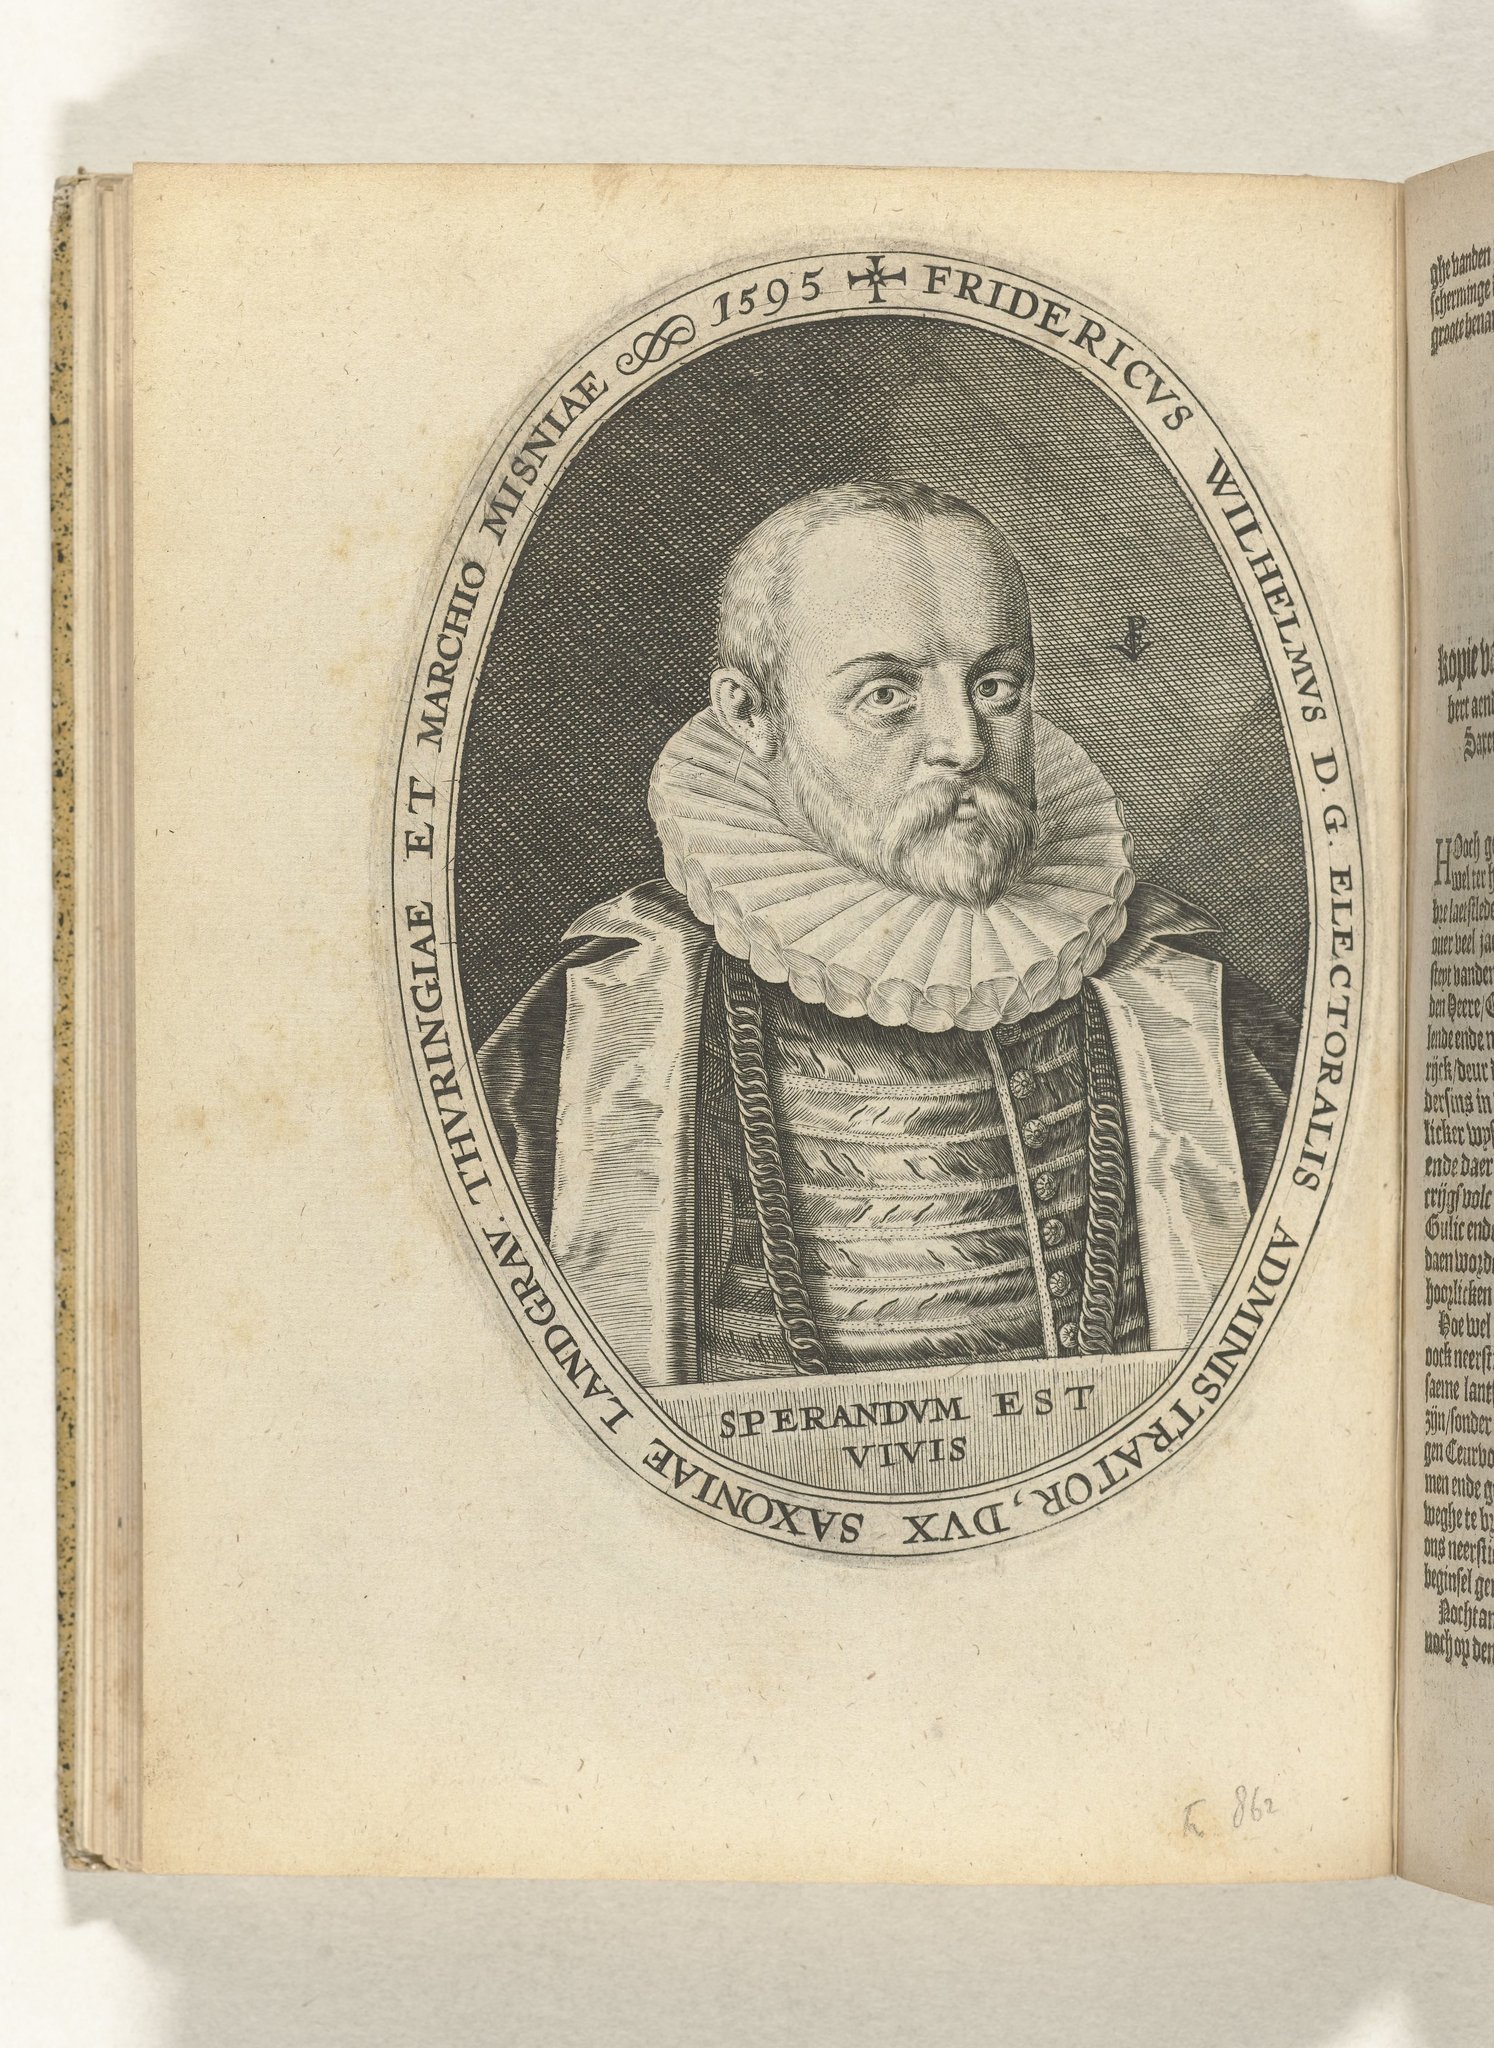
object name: print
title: Portret van Frederik Willem, hertog van Saxen-Weimar, 1595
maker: crispijn van de passe (i)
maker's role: draughtsman, print maker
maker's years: 1564-1637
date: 1595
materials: paper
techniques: engraving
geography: low countries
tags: weimar, hertog, frederik willem i (hertog van saksen-weimar), tachtigjarige oorlog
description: Portret van Frederik Willem, hertog van Saxen-Weimar, 1595. Ovaal portret met borstbeeld van de hertog, met randschrift in het Latijn. Opgenomen in het pamflet getiteld: Den Spaenschen ende Arragoenschen spiegel. Inde welcke men mach claerlick ende waerachtich sien tot wat eynde ... het voornemen is ... van 't Spaensche Crijchsvolck, dat hem desen Winter heeft gehouden in den Westphaelschen Creyts.